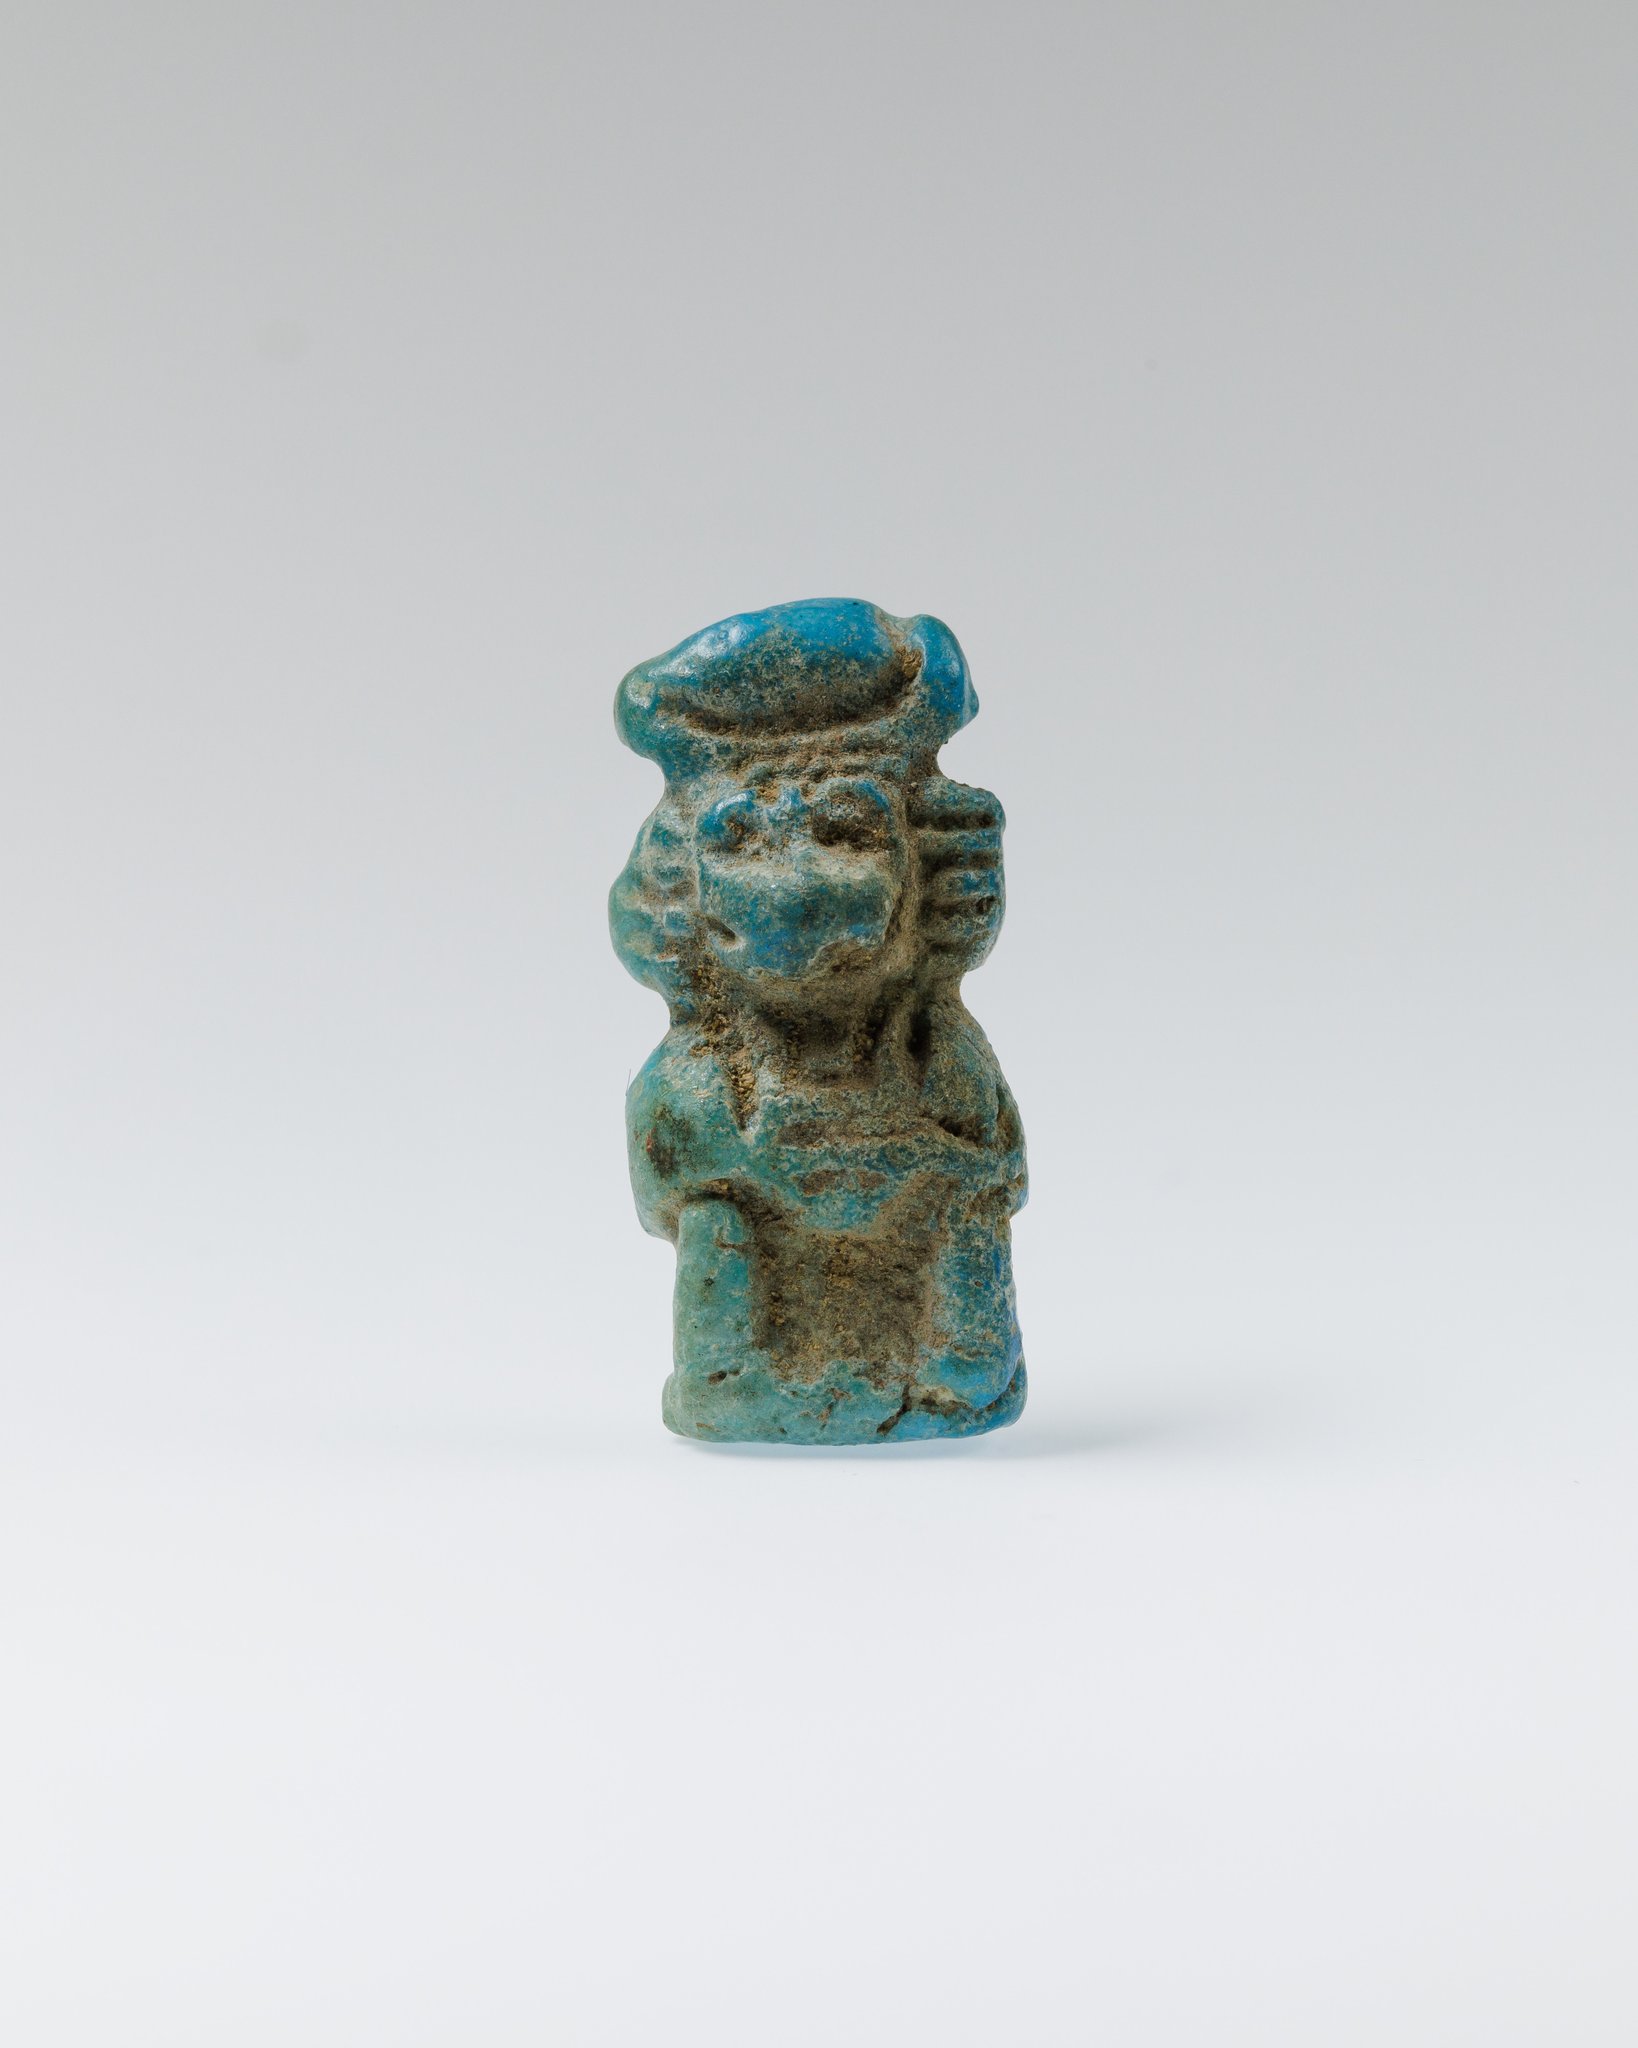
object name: amulet, baboon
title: Thoth (Cynocephalus baboon) amulet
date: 1295-1070 BCE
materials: faience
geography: egypt